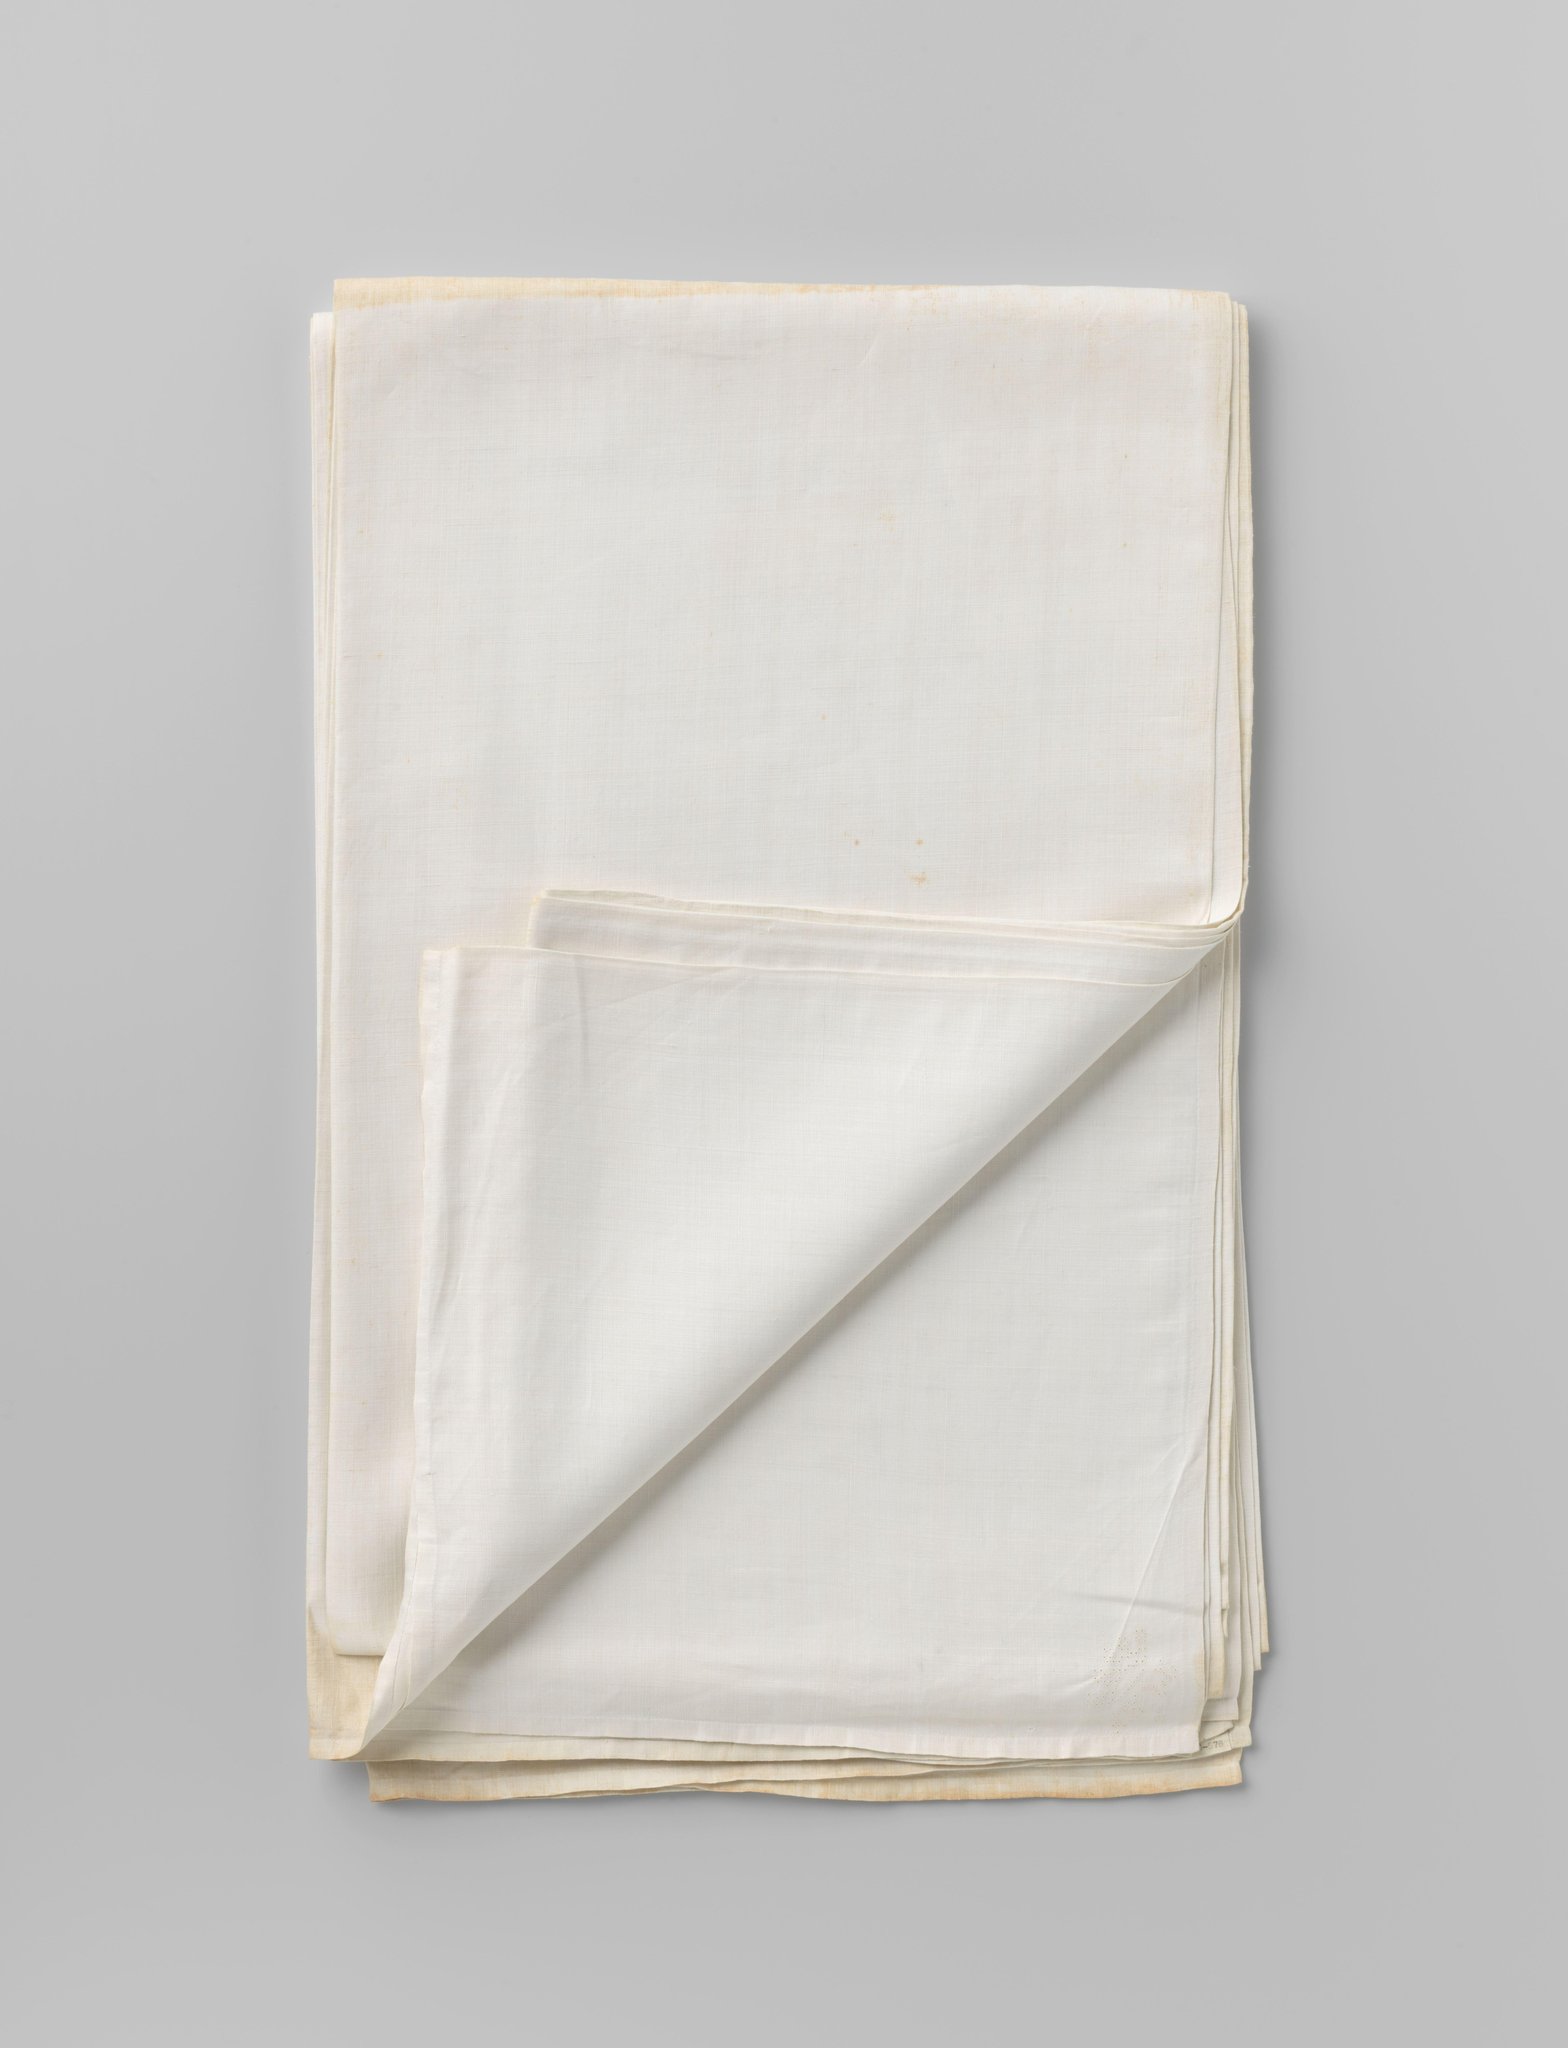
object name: beddenlaken, laken object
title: Laken. Merk: kroon FSVB6, HW13 en jaartal 1730.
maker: Anonymous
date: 1730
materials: linen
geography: northern netherlands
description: Laken van wit linnen, merk kroon FSVB 6 en 1730 en HW1 3